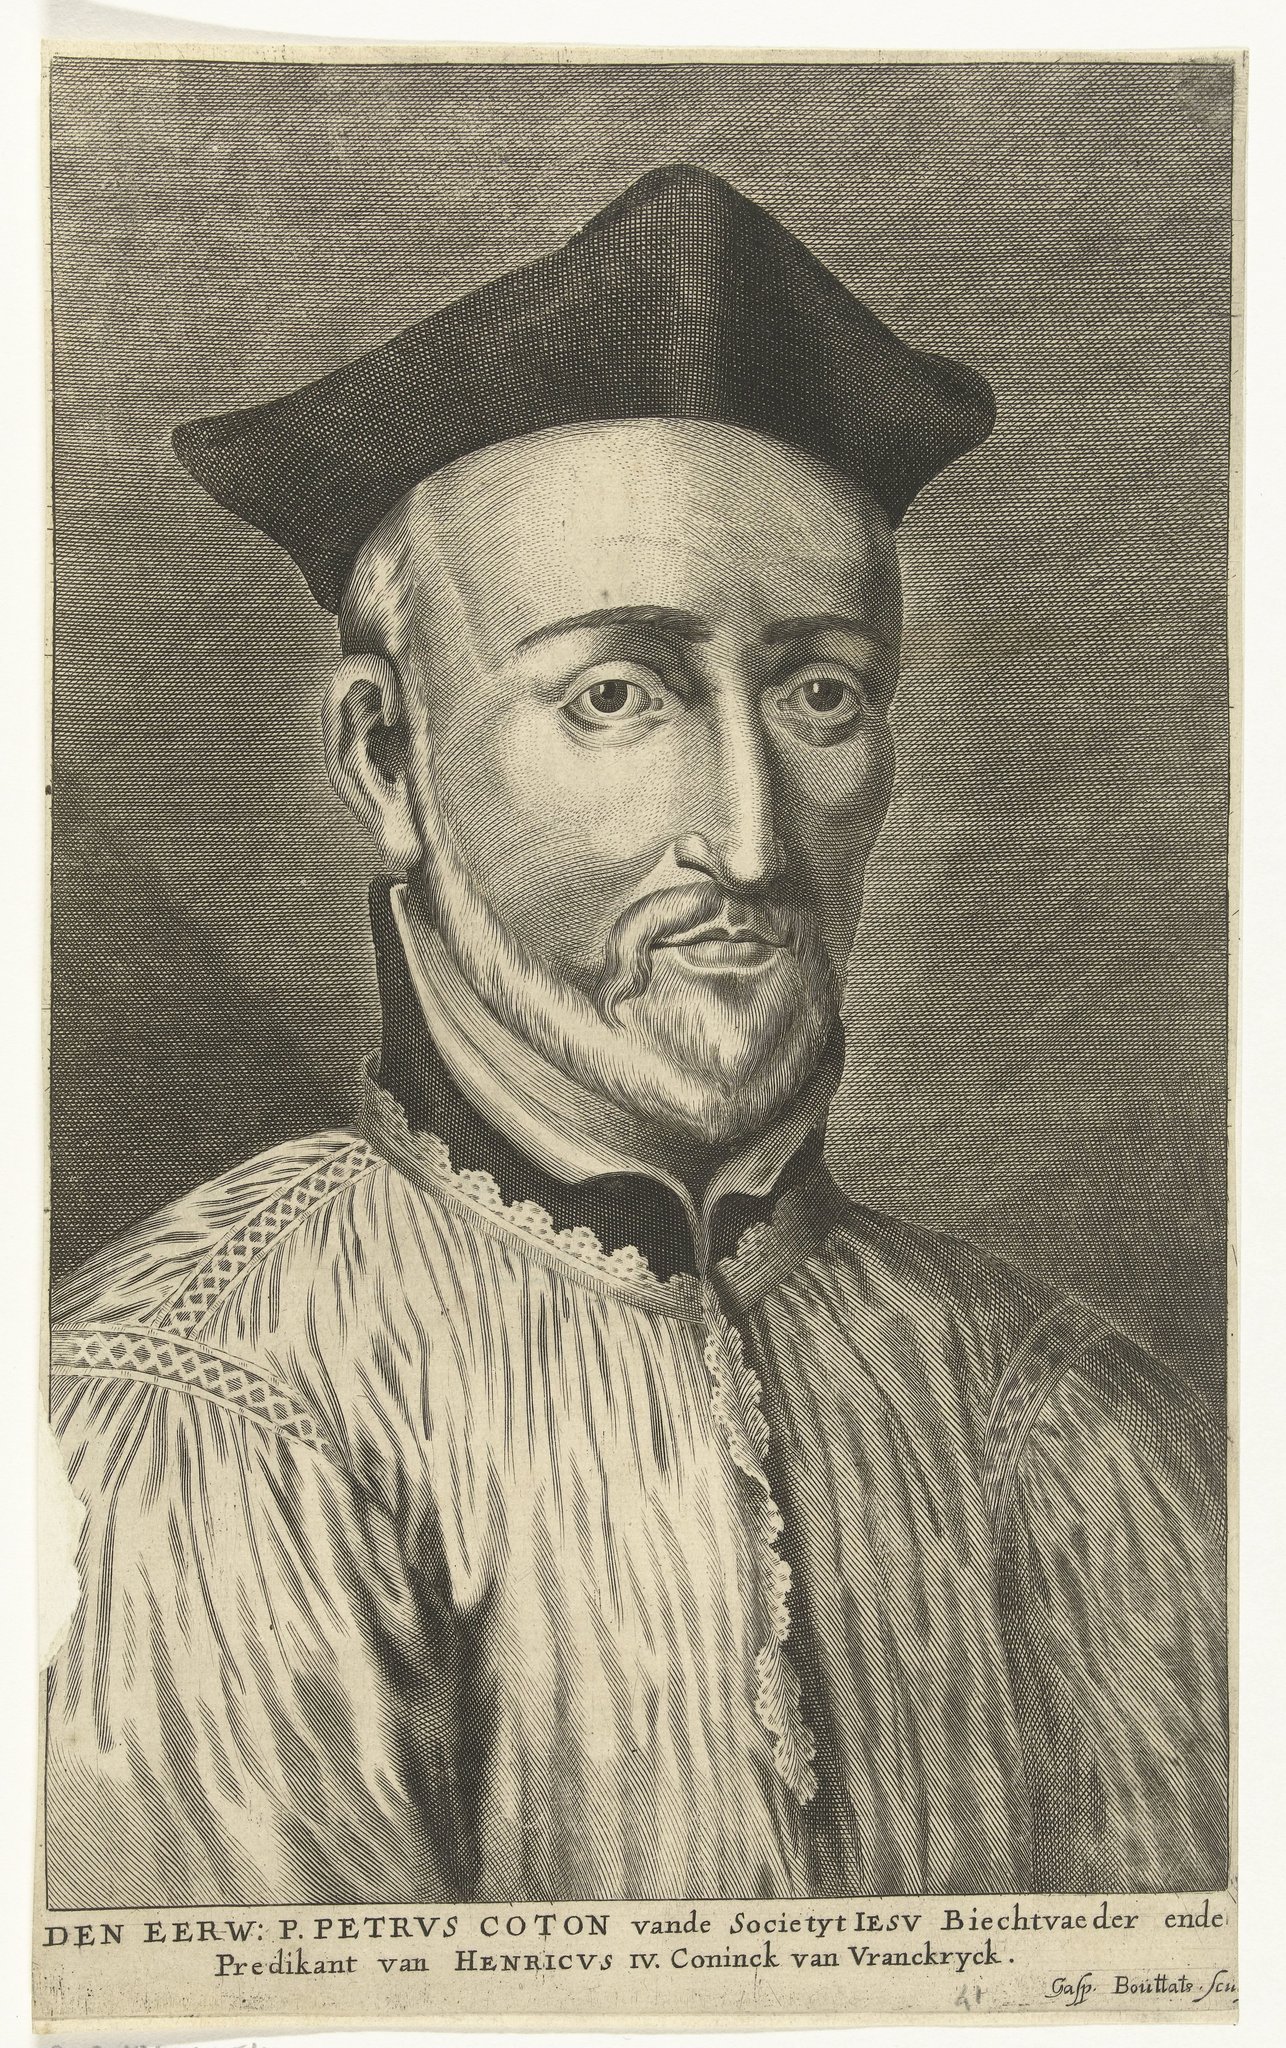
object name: print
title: Den Eerw. P. Petrus Coton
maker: gaspar bouttats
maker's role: print maker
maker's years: 1640-1695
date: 1650-1695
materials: paper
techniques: engraving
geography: antwerp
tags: hendrik iv (koning van frankrijk en navarra), lodewijk xiii (koning van frankrijk), head-gear (biretta) (+ men's clothes), regular clerics, e.g. jesuits, redemptorists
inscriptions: collector's mark: Lugt 2228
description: Pierre Coton, Jezuïet en biechtvader van Hendrik IV van Frankrijk. Buste naar rechts. Pierre Coton draagt een koorhemd over zijn soutane en heeft een zwarte biretta op het hoofd. De prent heeft een Nederlands onderschrift.